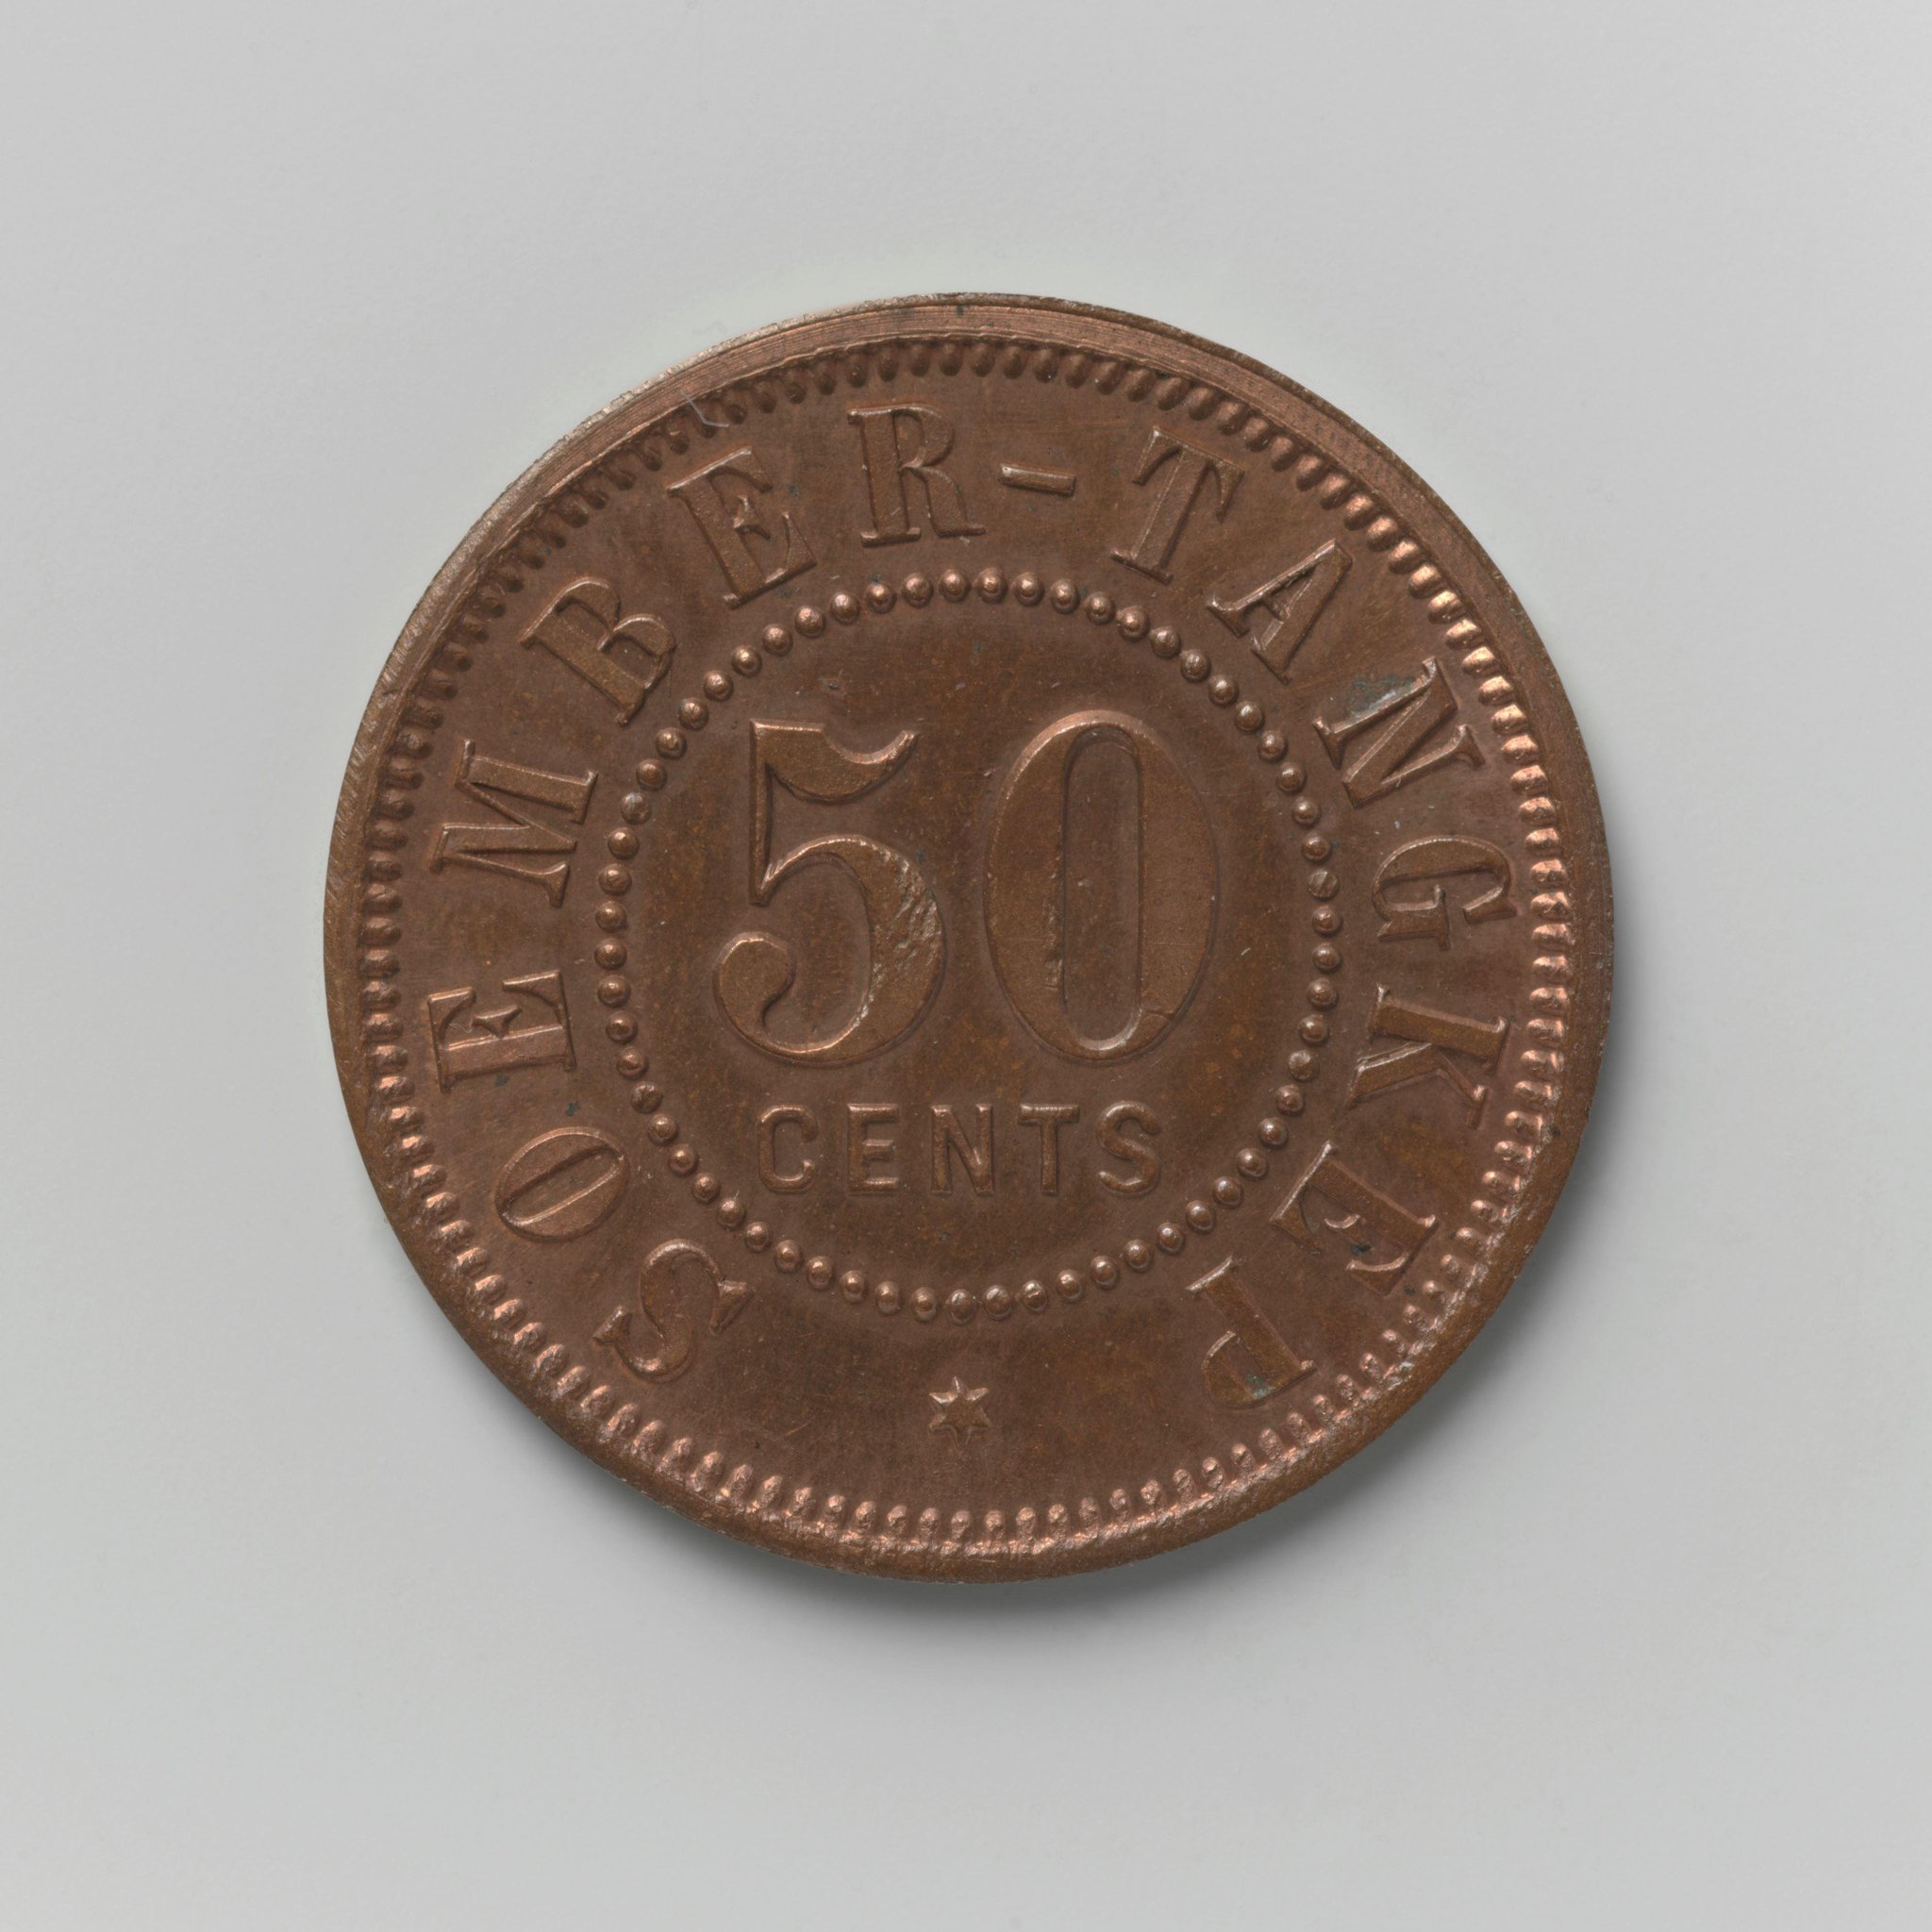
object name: monetary token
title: Plantage Soember Boeren, 50 cents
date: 1875-1925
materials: copper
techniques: striking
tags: plantage soember-tangkep, passoeroean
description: Koperen partuculiere munt. Plantage-geld. Voorzijde: in twee regels waarde-aanduiding. In omschrift aanduiding van de plantage. Keerzijde: in twee regels waarde-aanduiding. Gladde rand.